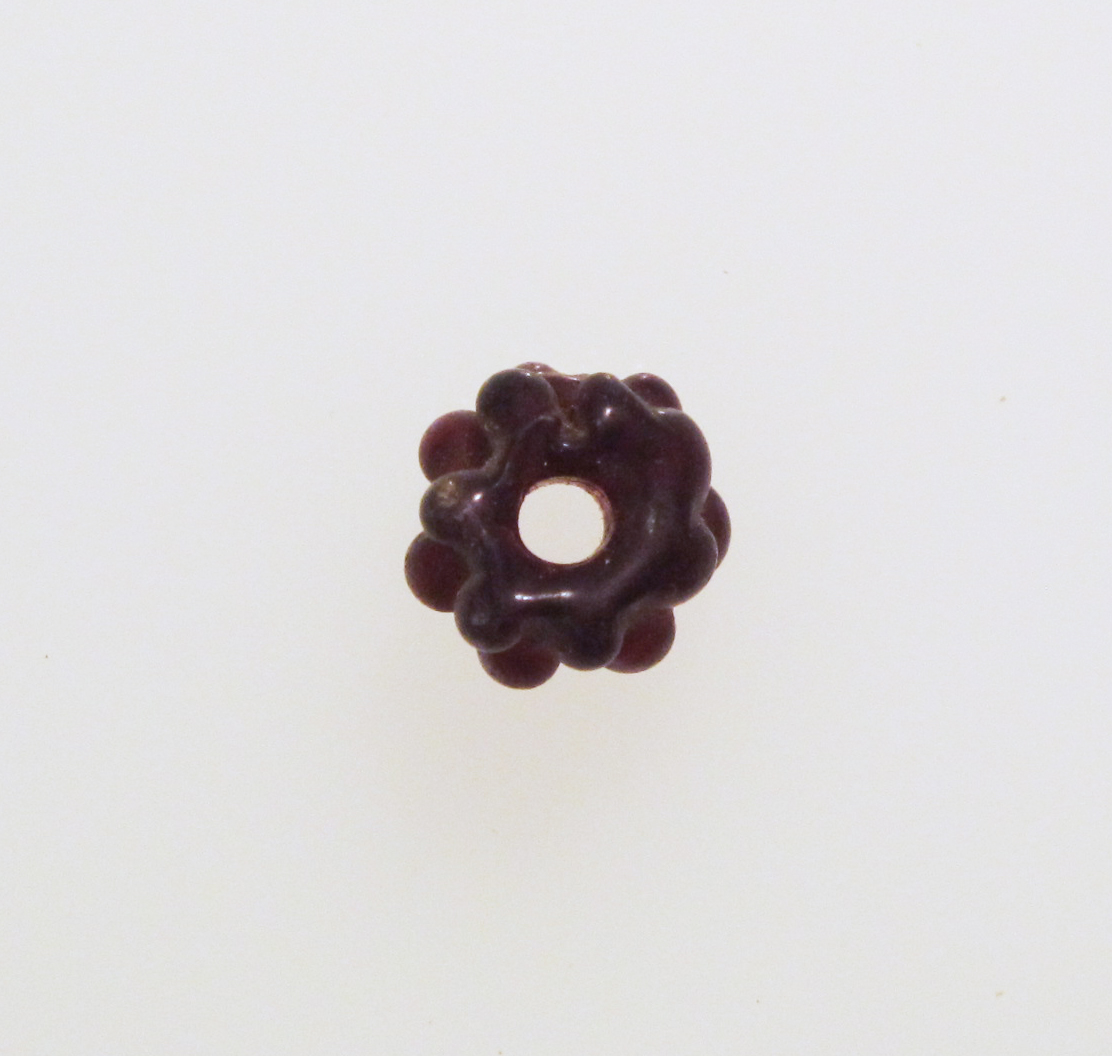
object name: bead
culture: roman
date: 670 BCE-330 CE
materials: glass